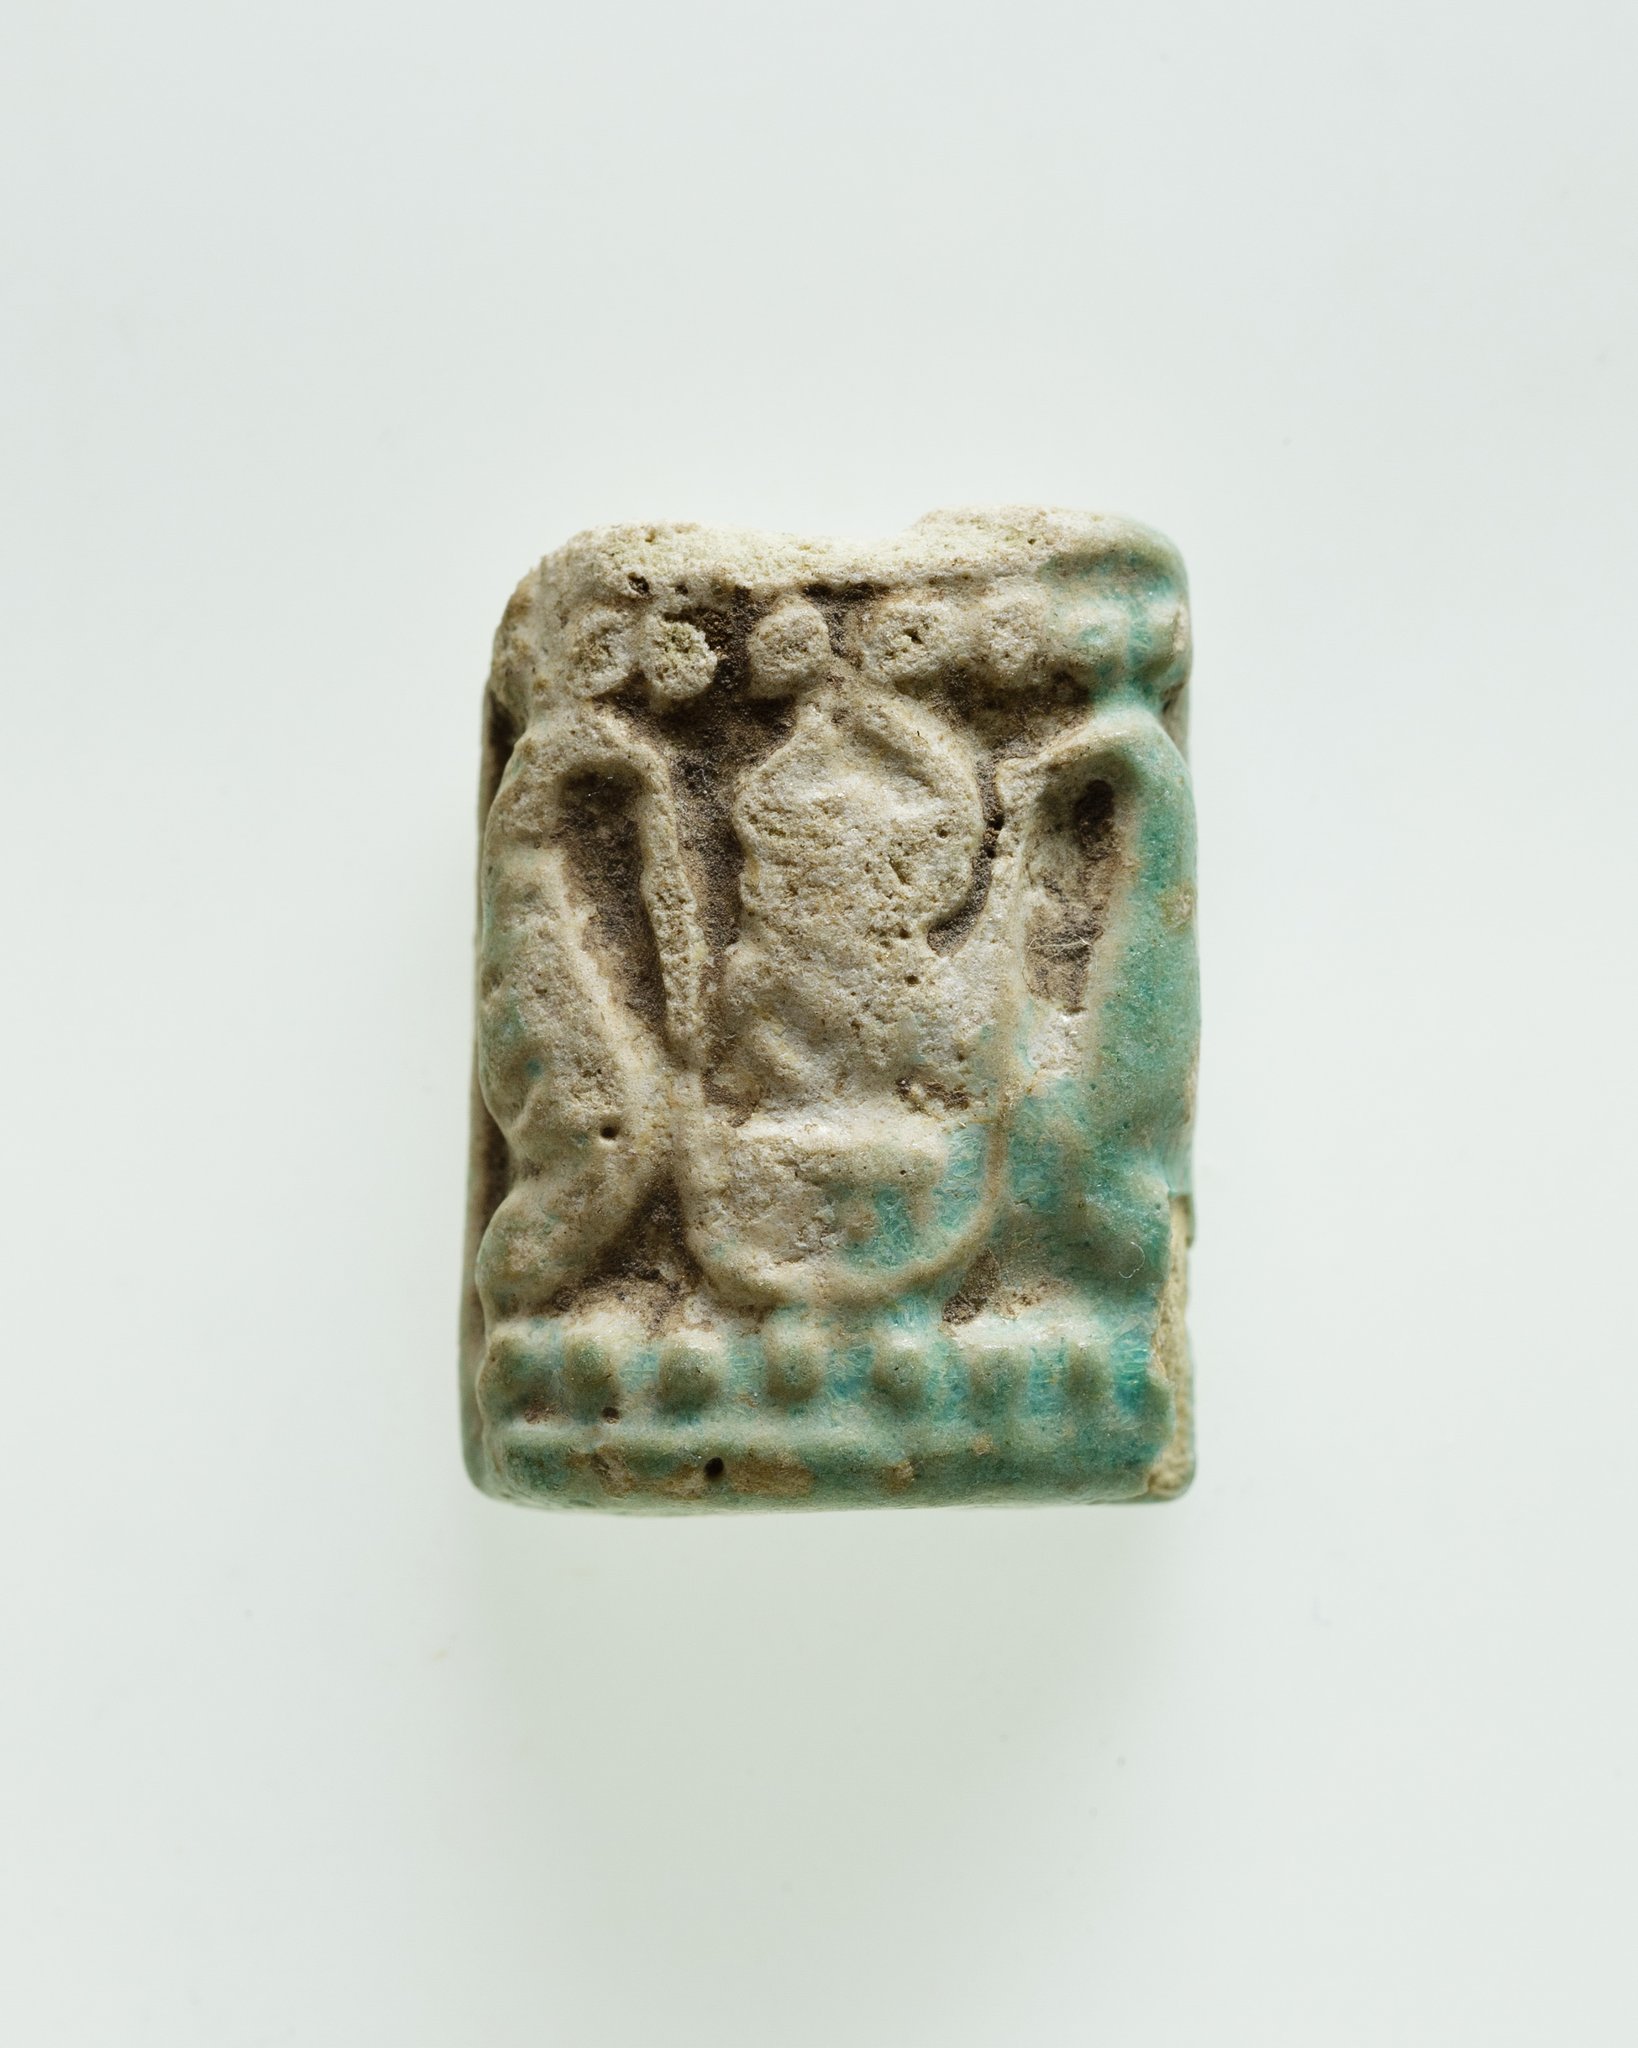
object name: plaque, uraei, beetle, winged falcon headed sun god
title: Plaque with winged Re-Harakhty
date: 1295-1070 BCE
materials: stone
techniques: glazing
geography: egypt